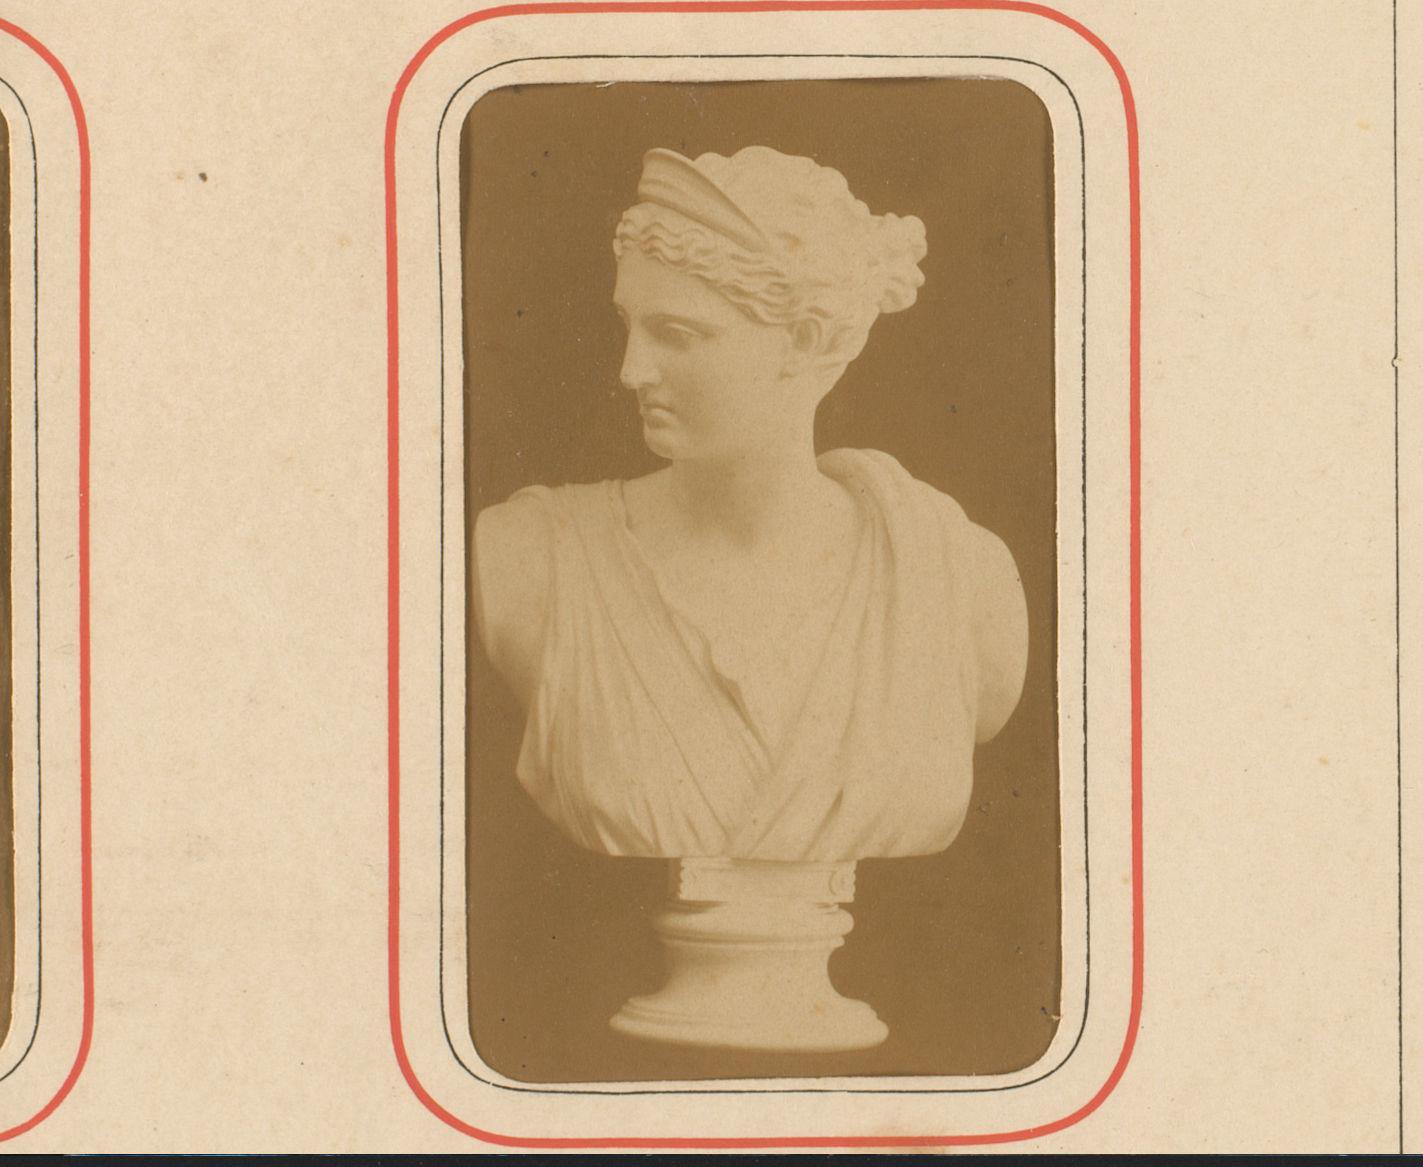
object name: carte de visite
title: Diana von Versailles, antik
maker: Anonymous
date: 1870-1890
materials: cardboard, paper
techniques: albumen print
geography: paris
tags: sculpture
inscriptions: number: ‘332.’